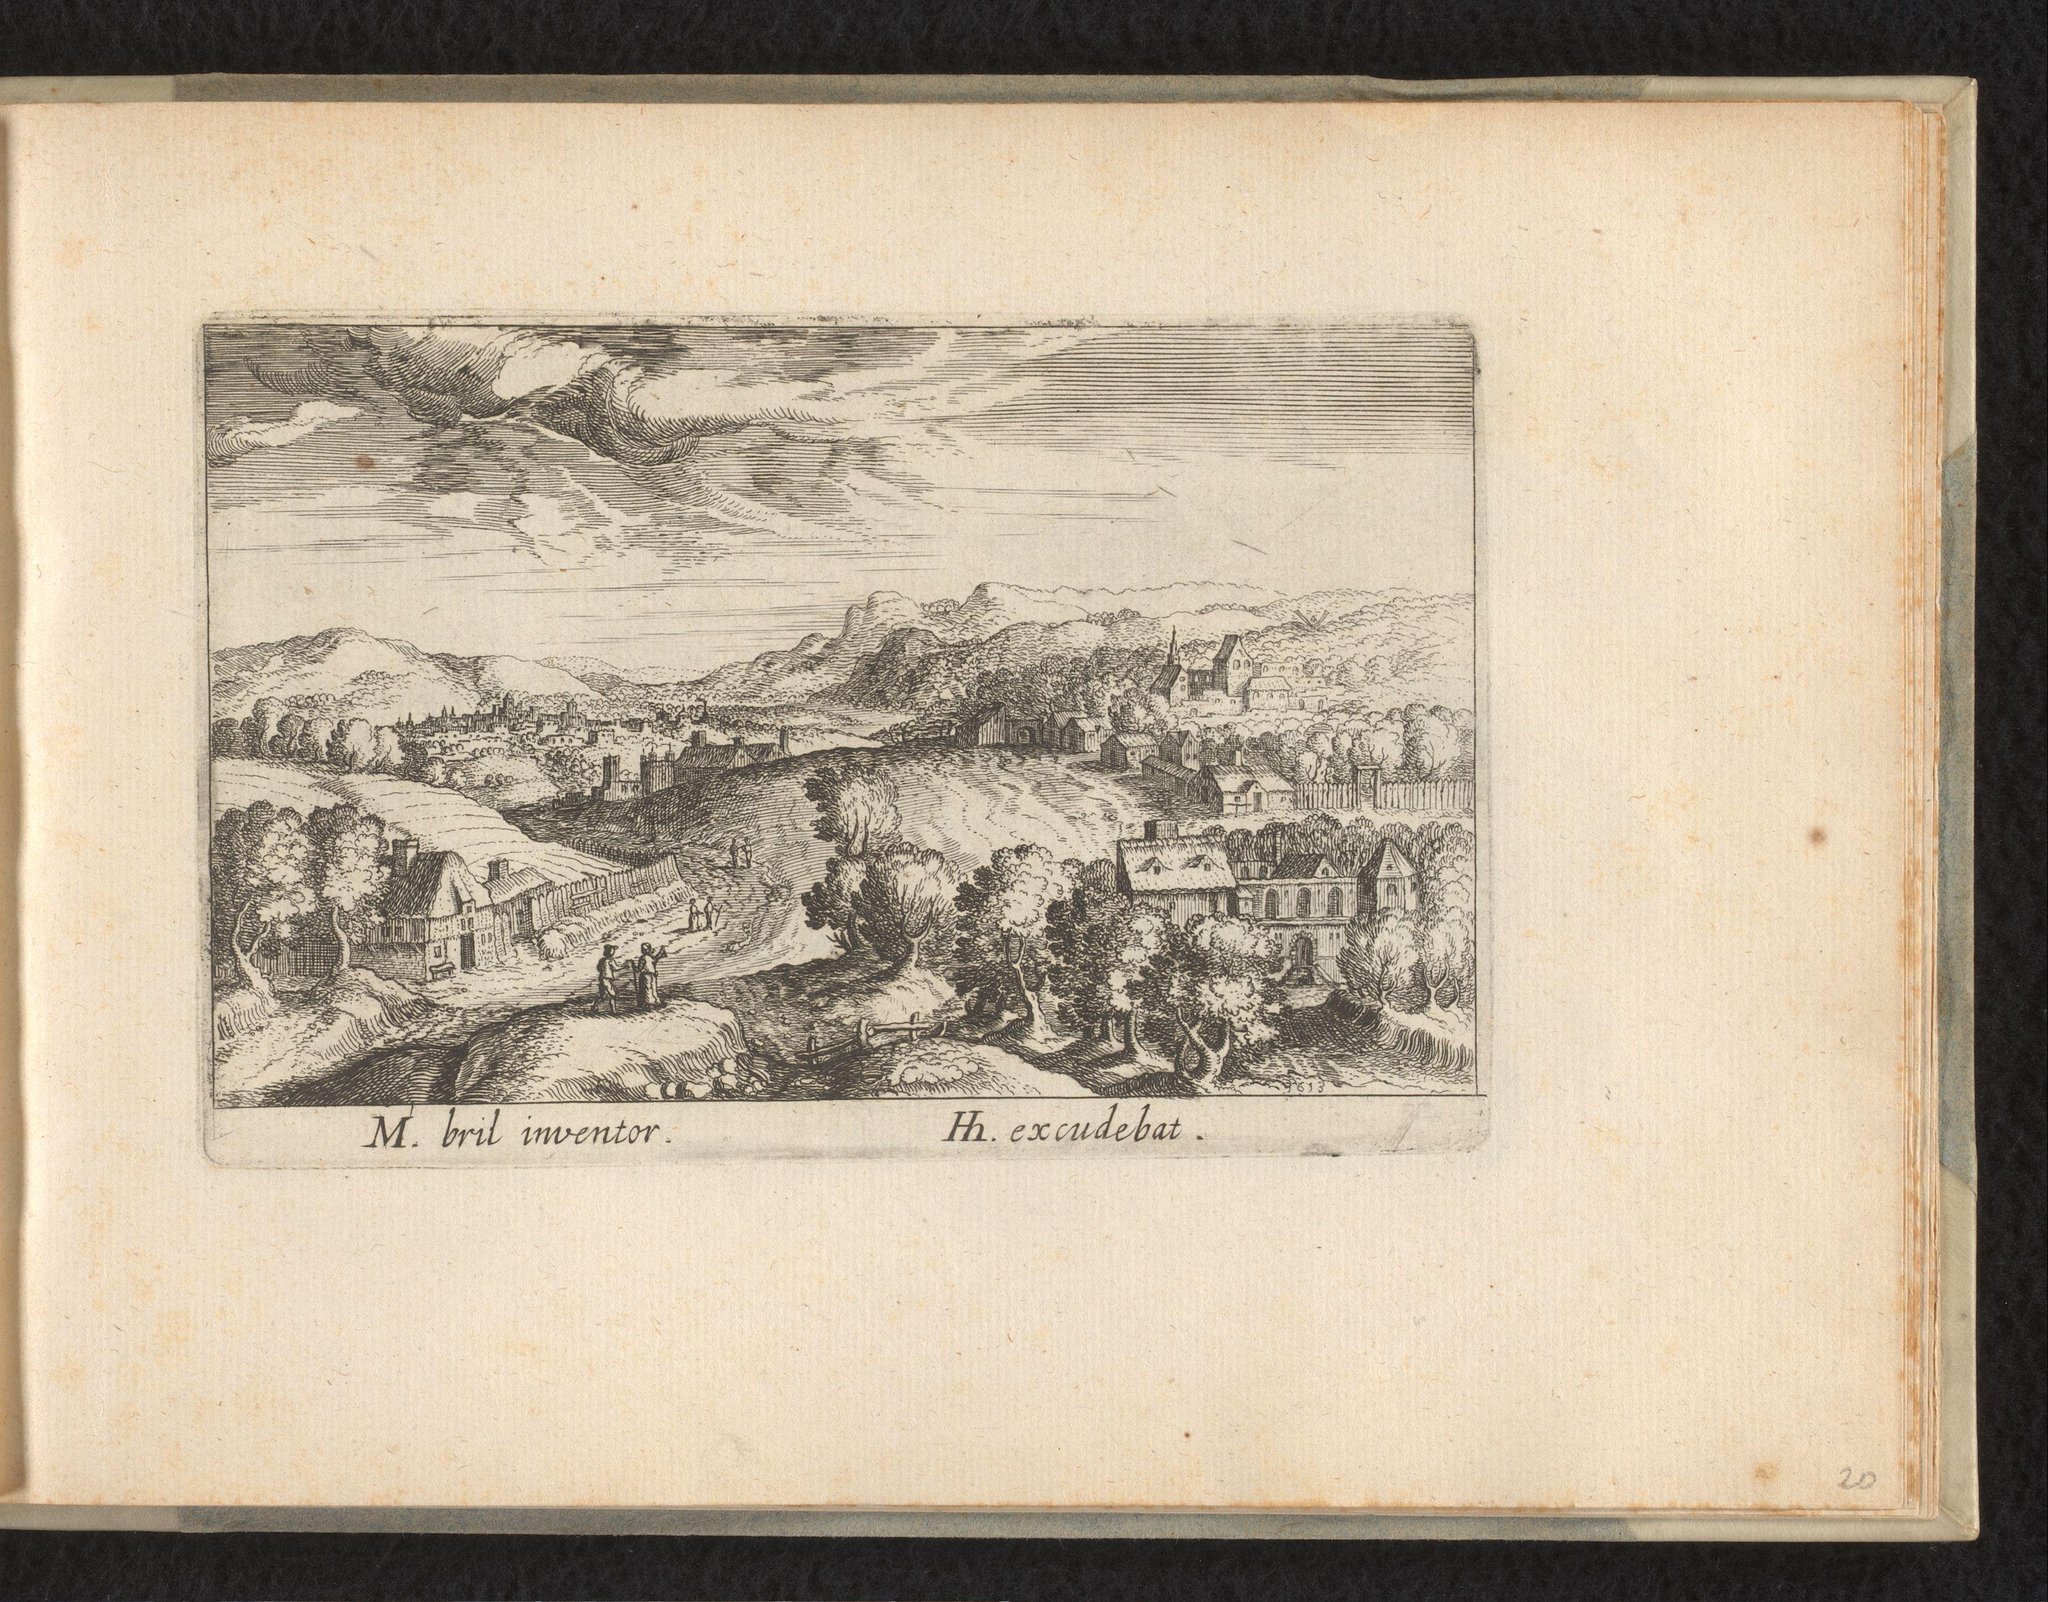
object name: print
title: Heuvellandschap met bomen en verspreid liggende huizen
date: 1614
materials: paper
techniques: etching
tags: landscapes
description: Heuvelachtig landschap met velden en bomen. Tussen de bomen lage huizen. Op de voorgrond figuurtjes op een landweg.